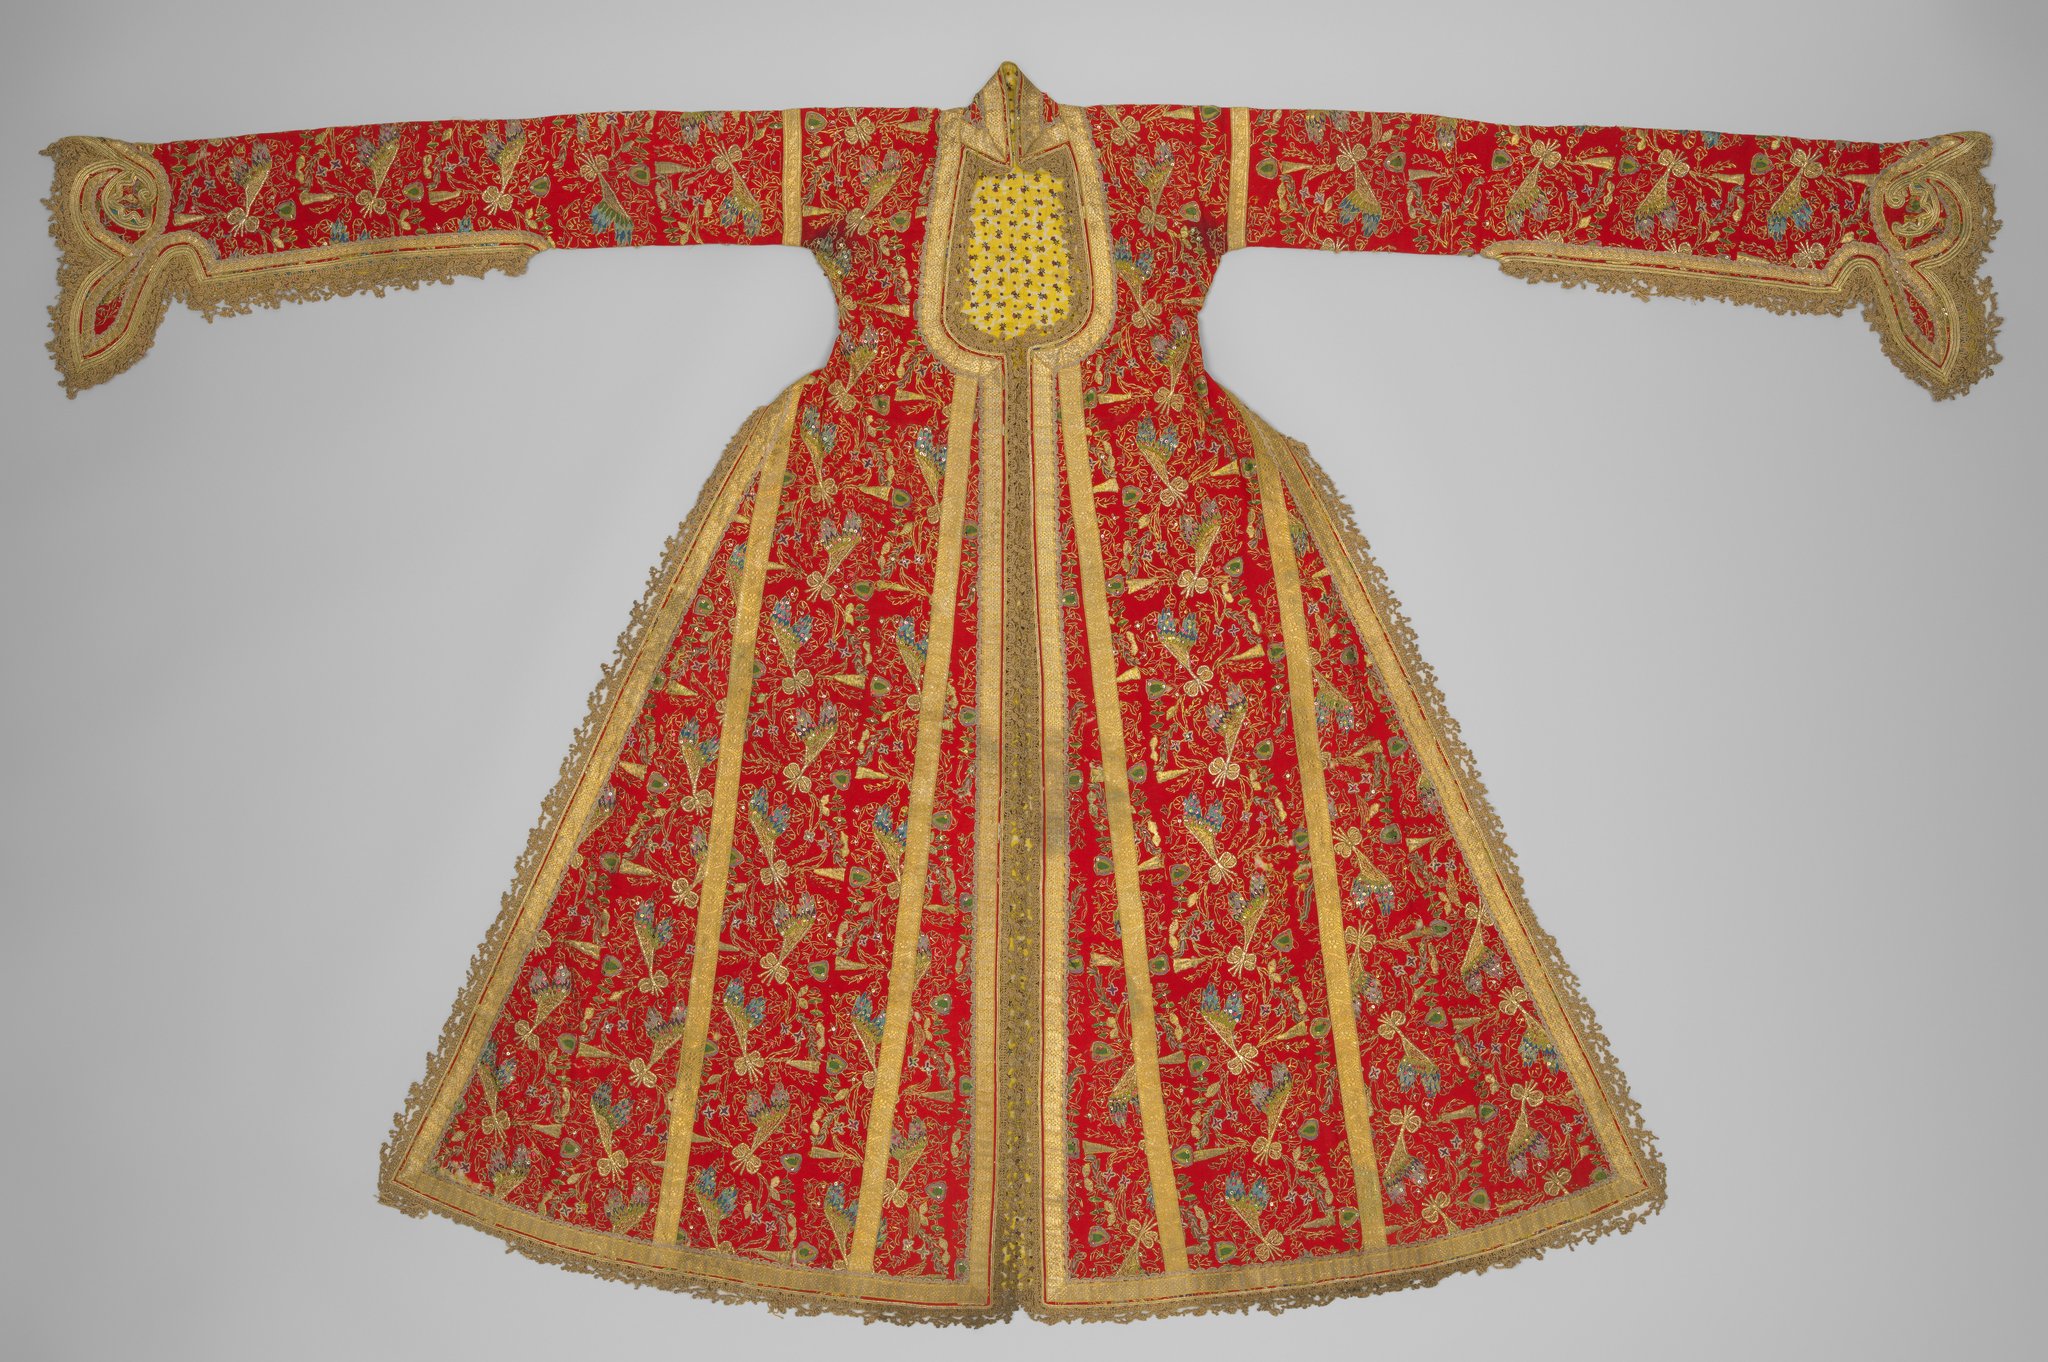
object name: robe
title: Uçetek Entari or Three-Skirt Robe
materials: fiber, metal thread, silk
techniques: embroidery, weave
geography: balkans